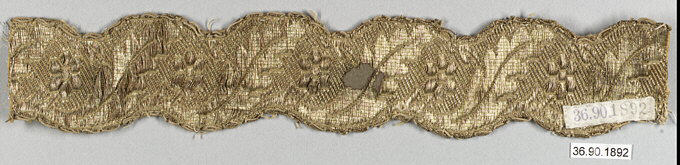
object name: galloon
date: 1767-1833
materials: metal thread, silk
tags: flowers